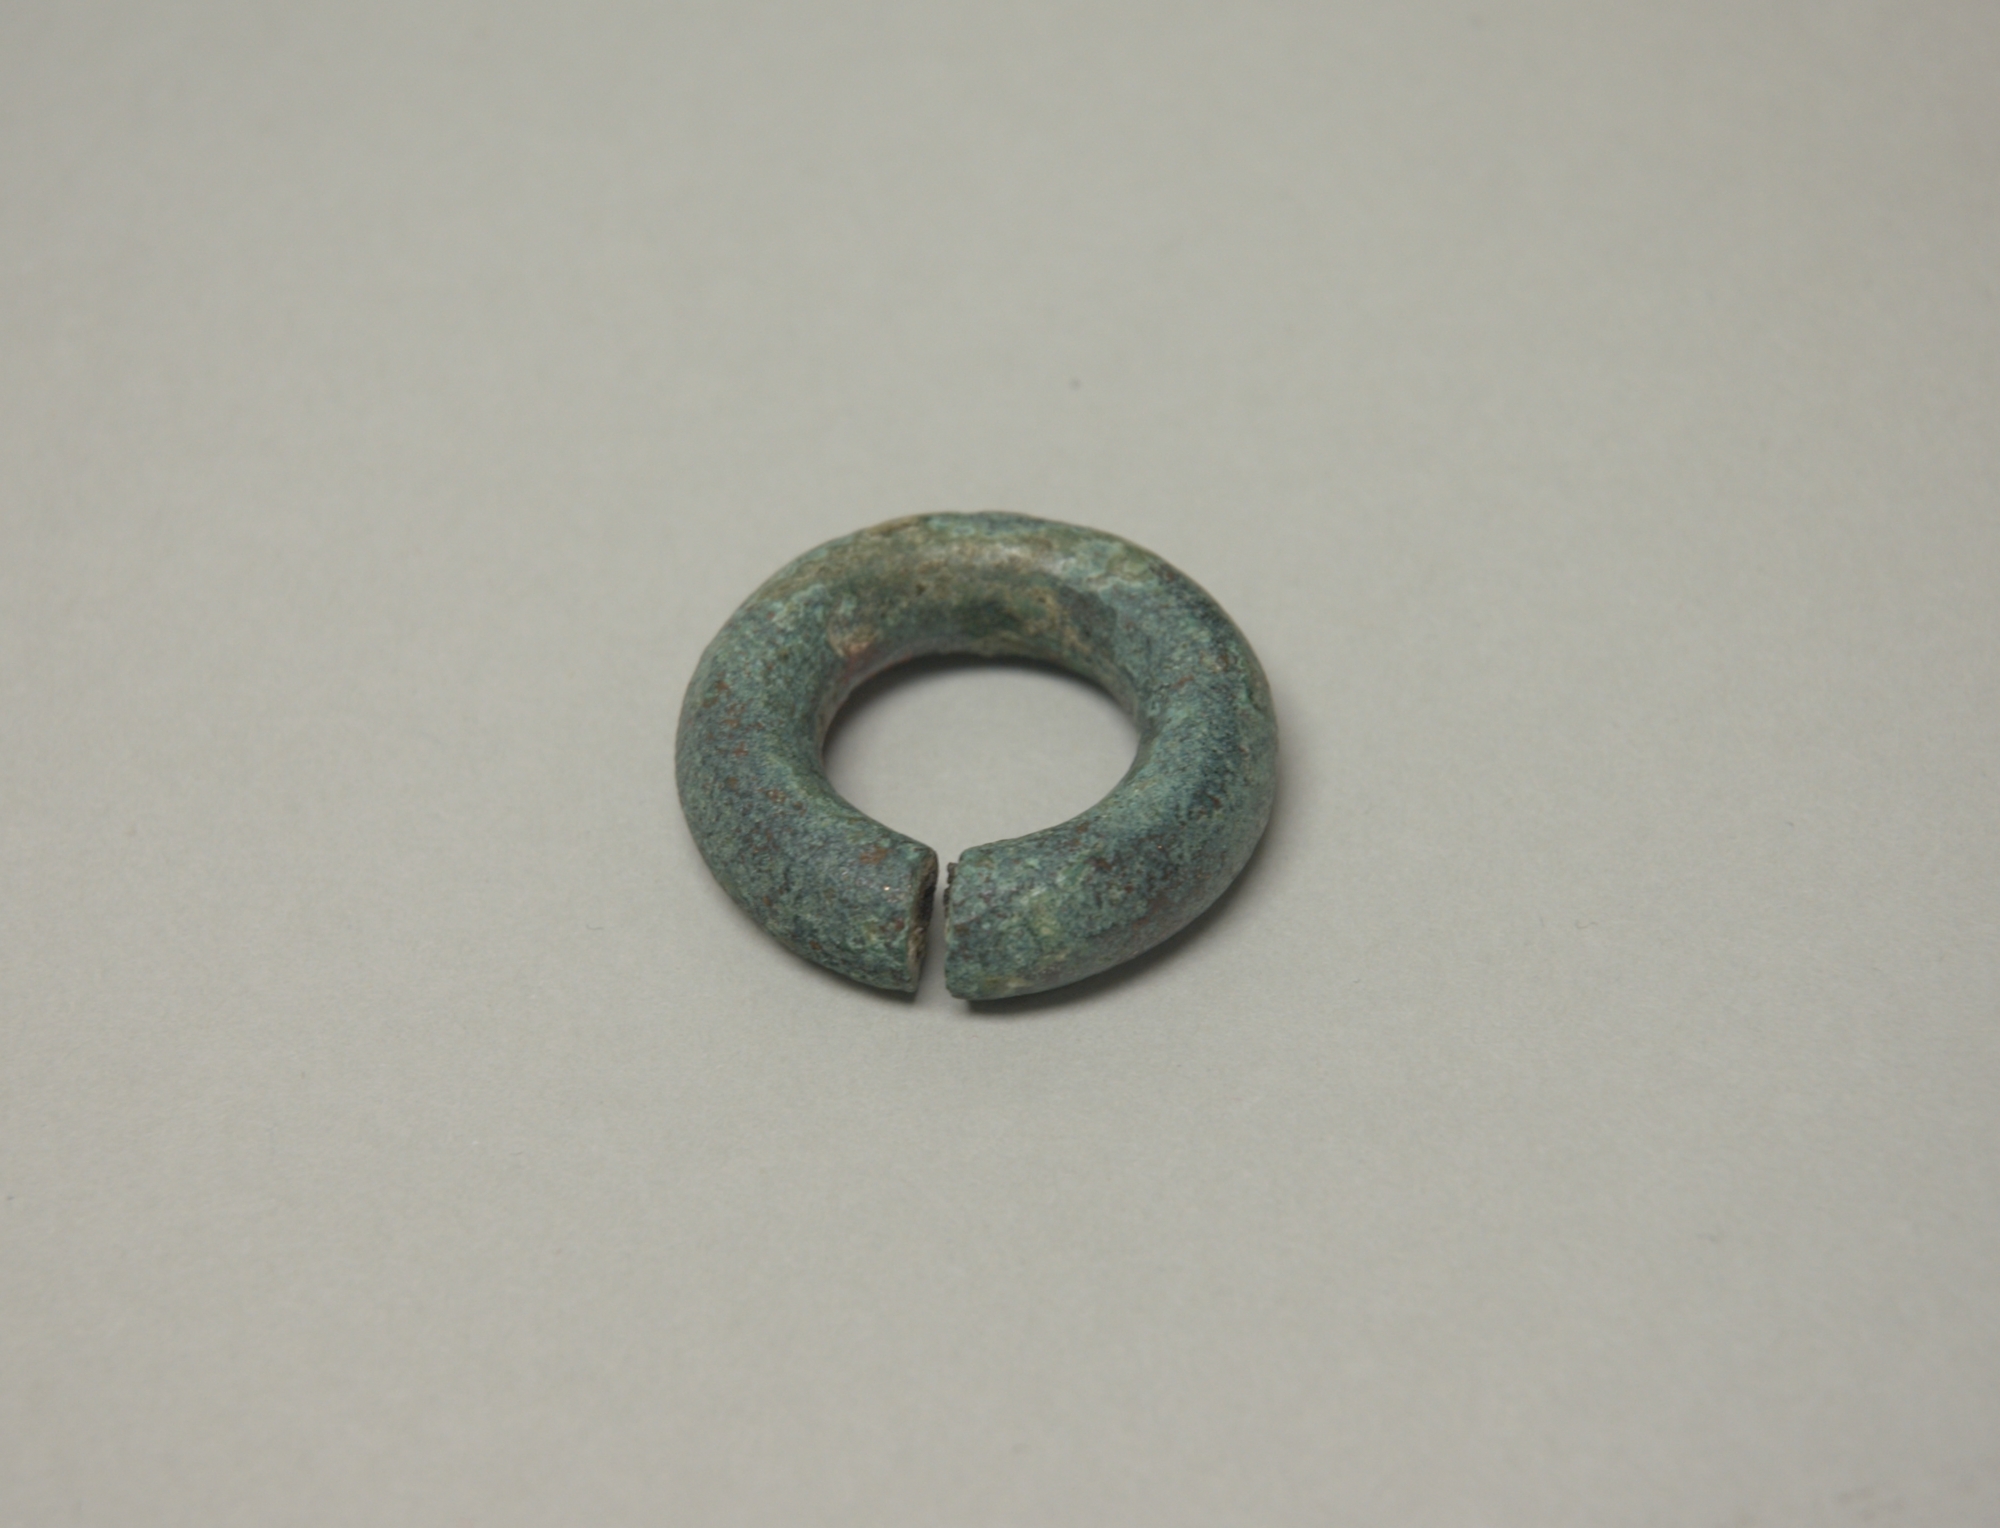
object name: earring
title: Ring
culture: thai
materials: bronze